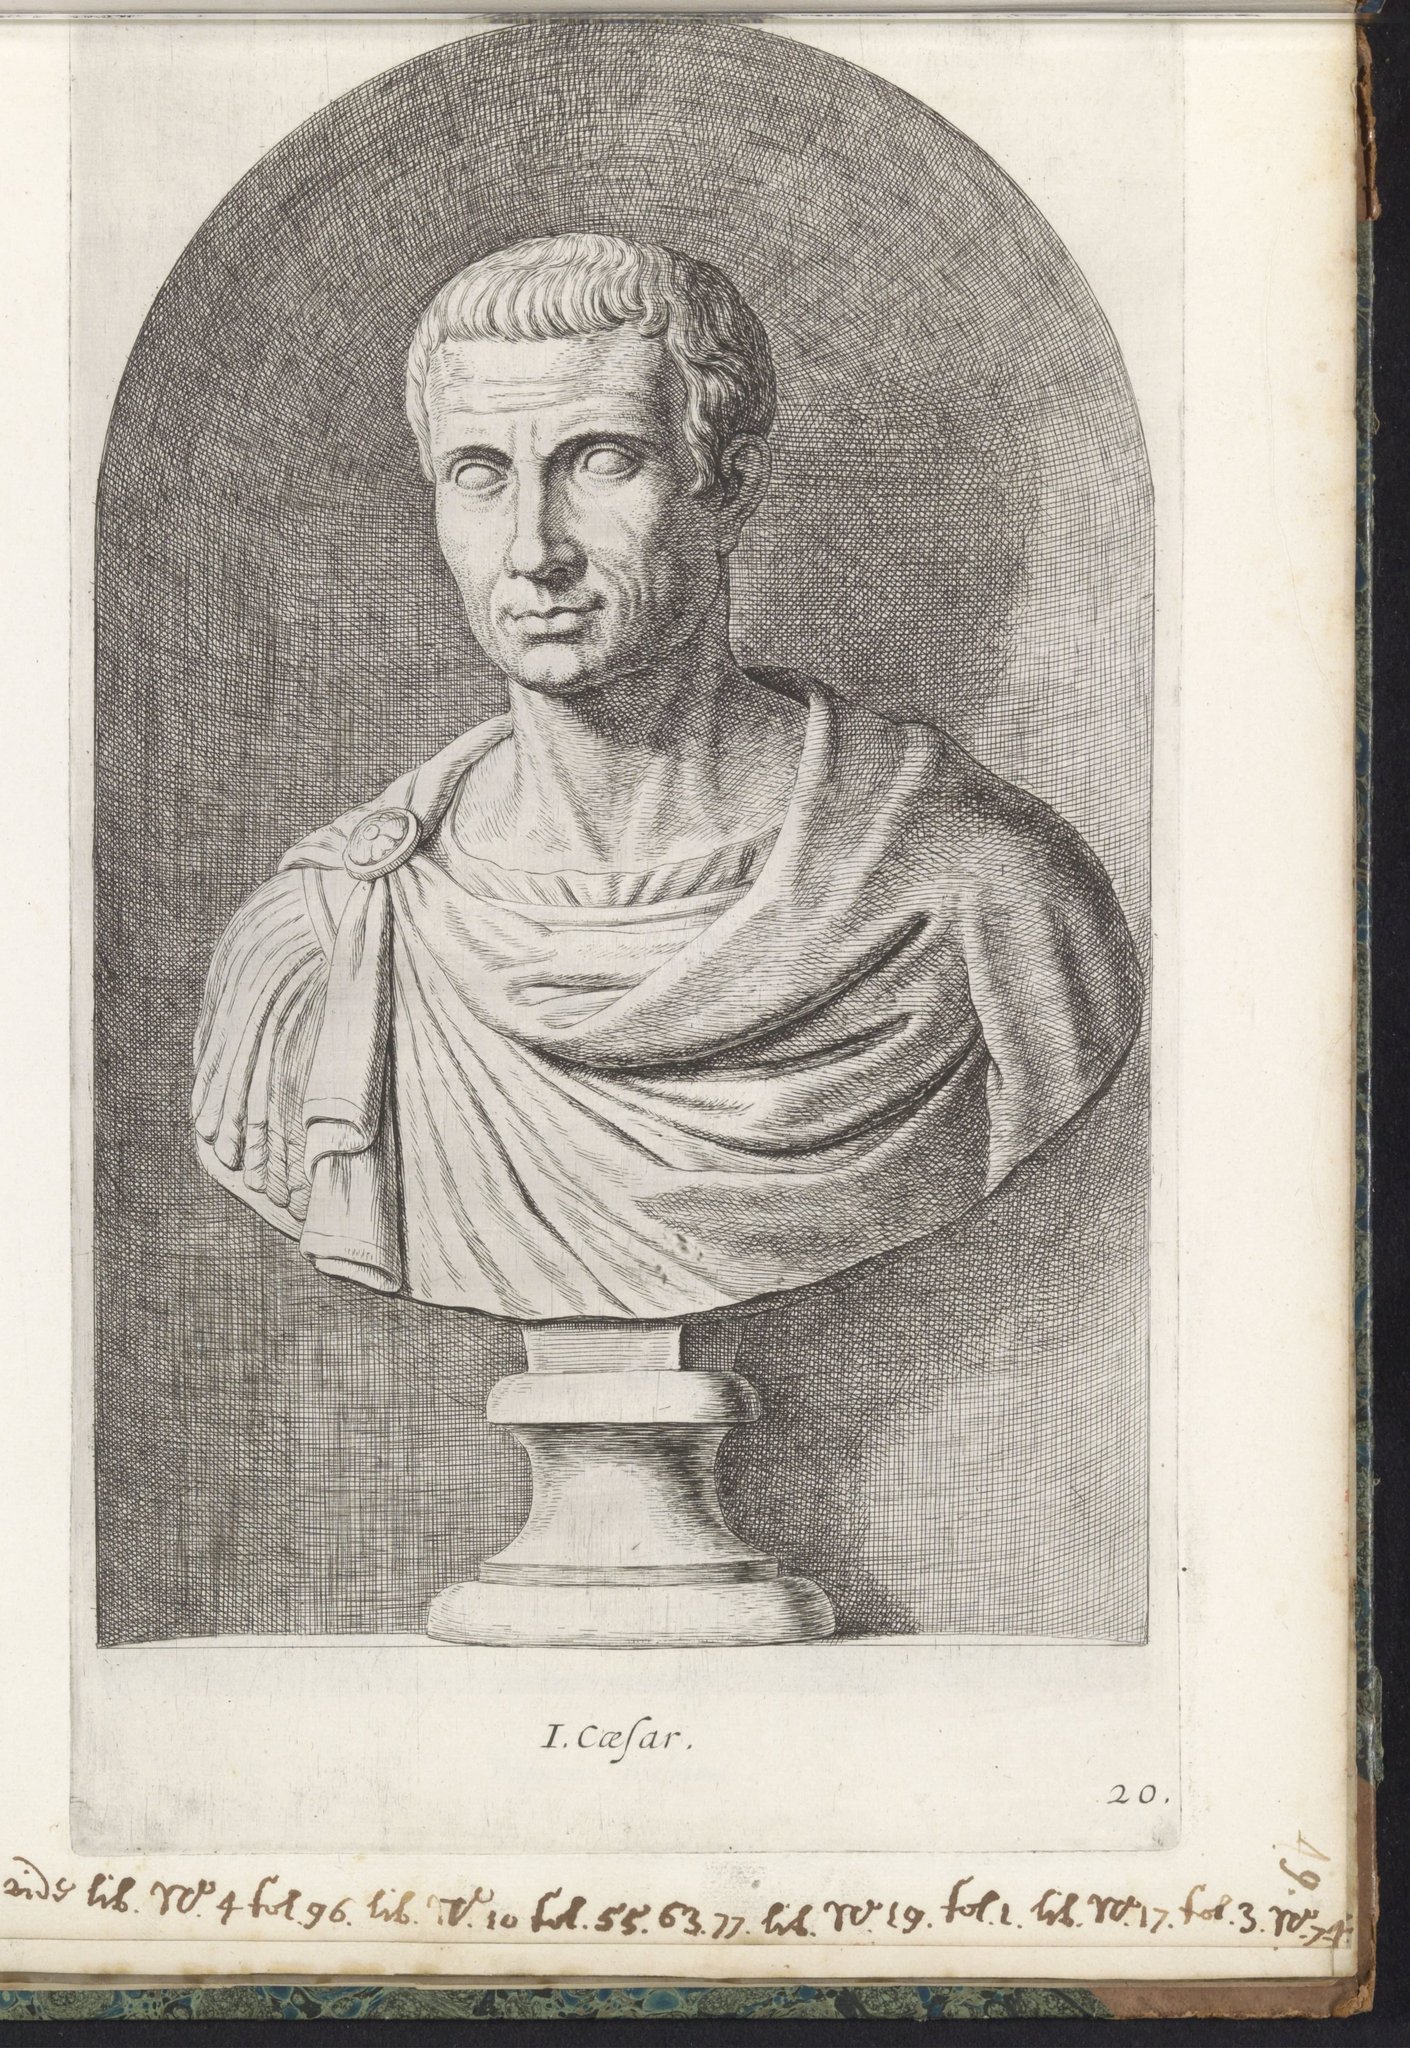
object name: album leaf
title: J. Caesar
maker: hubert quellinus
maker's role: print maker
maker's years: 1619-1687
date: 1646-1670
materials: paper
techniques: engraving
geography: antwerp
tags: rome, piece of sculpture, reproduction of a piece of sculpture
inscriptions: number: ‘49’, inscription: ‘Vide lib. No. 4de fol. 96. lib. No. 10 fol. 55, 63, 77...’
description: Klassieke buste van een man. De prent maakt deel uit van een album met een serie prenten naar de sculpturen in de verzameling van Gerard Reynst.